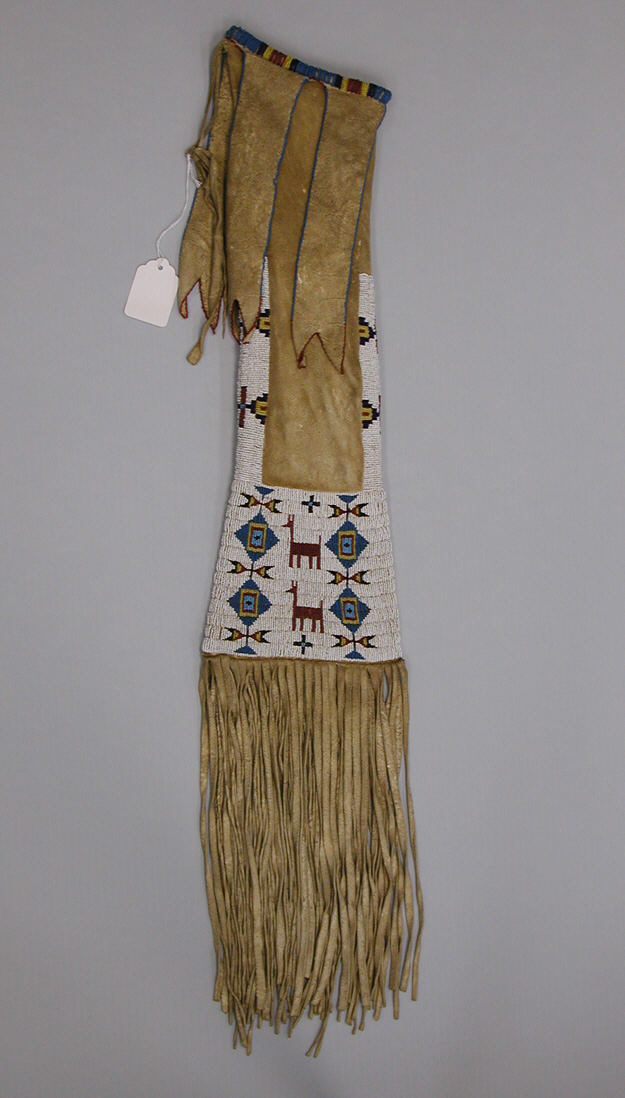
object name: pipe bag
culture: cheyenne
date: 1890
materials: textile, glass, leather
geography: united states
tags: deer